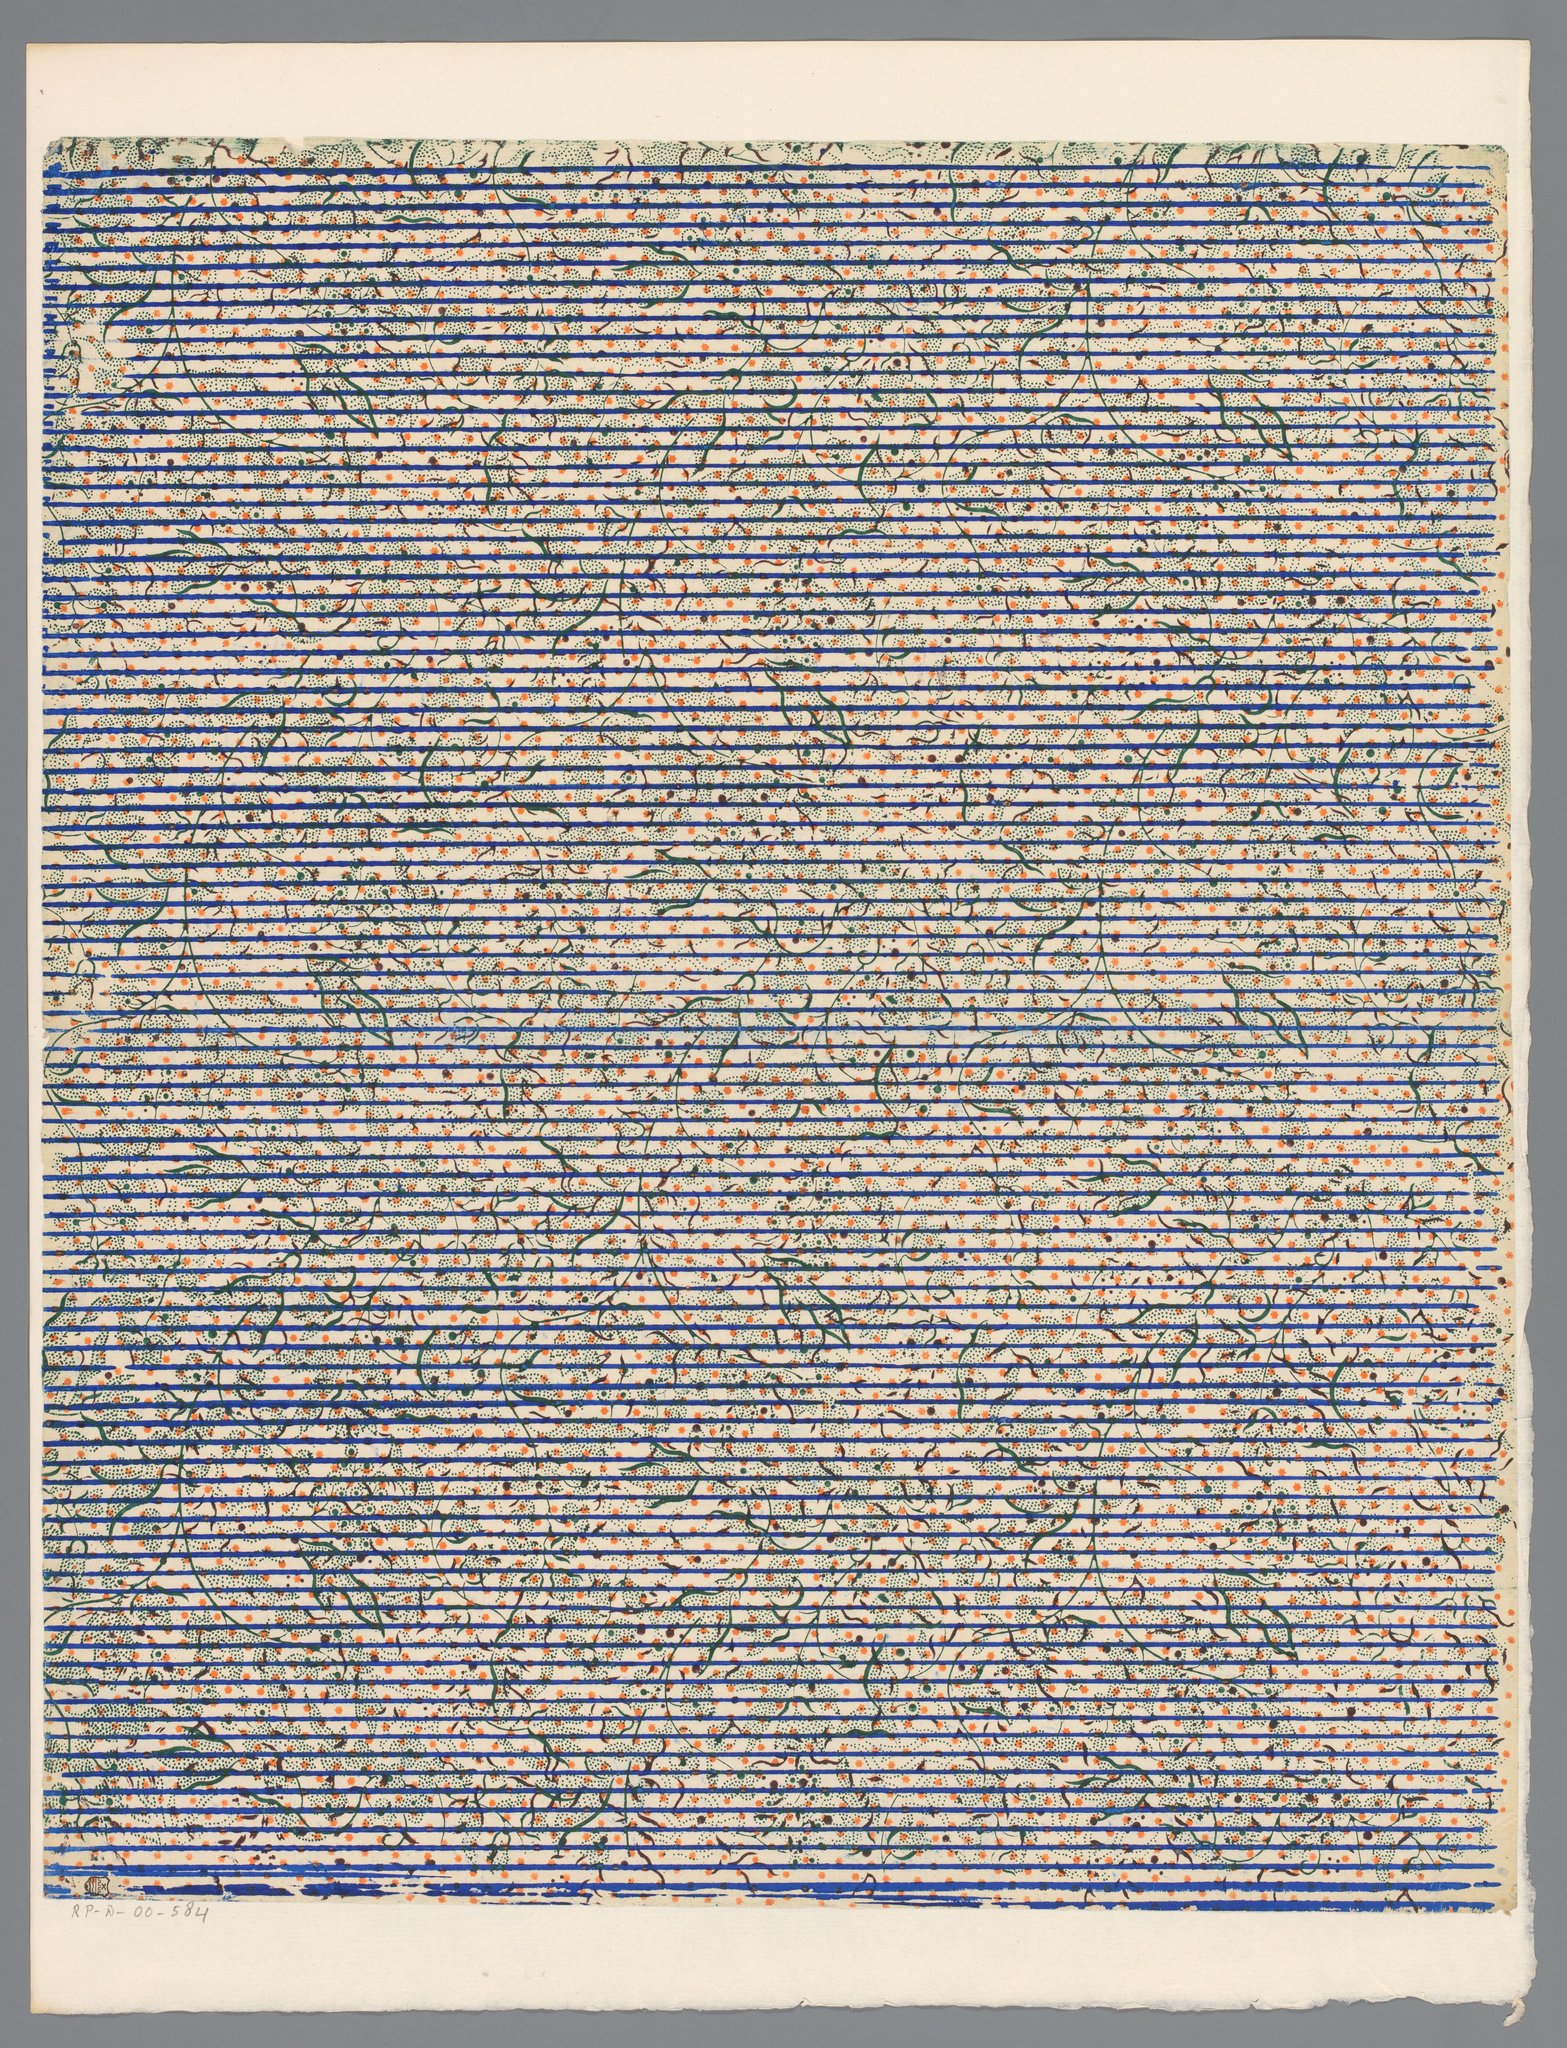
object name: printed paper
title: Blad met lijnenpatroon over strooipatroon van ranken in stippen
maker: Anonymous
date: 1800-1900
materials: paper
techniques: printing block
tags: ornament derived from plant forms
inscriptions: collector's mark: Lugt 2760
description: Blad met verticaal lijnenpatroon over een strooipatroon van gestippelde ranken en sterren.